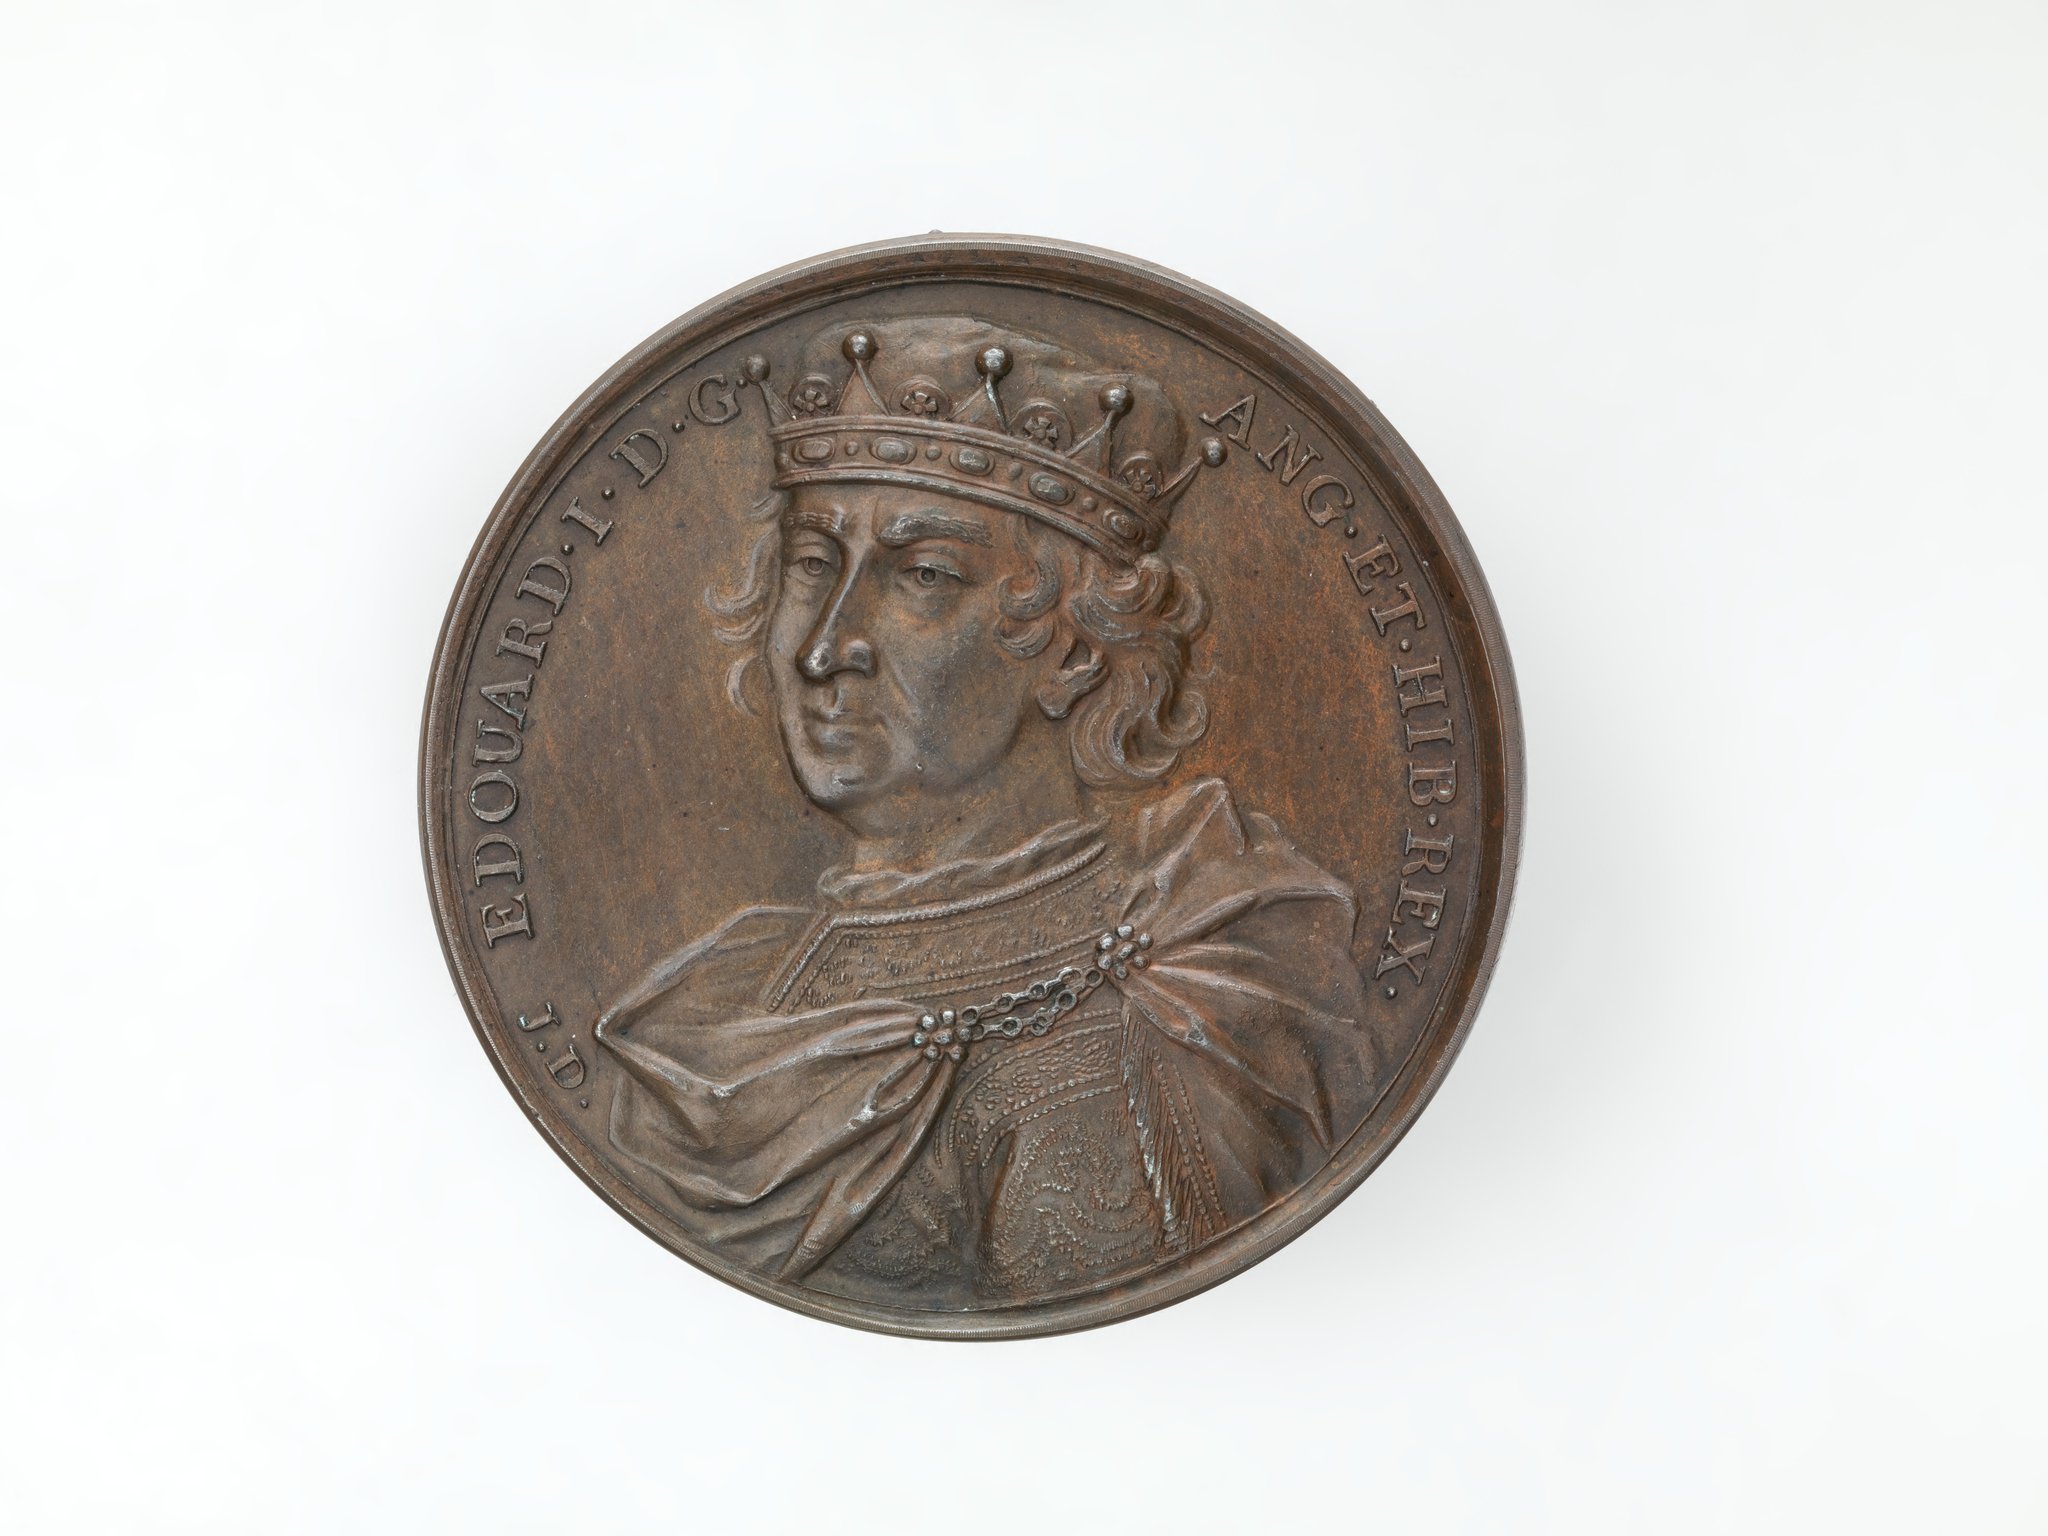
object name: medal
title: Edward I, from the English Monarchs series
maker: jean dassier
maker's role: artist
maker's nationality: swiss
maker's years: 1676-1763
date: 1731-1732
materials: bronze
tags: kings,men